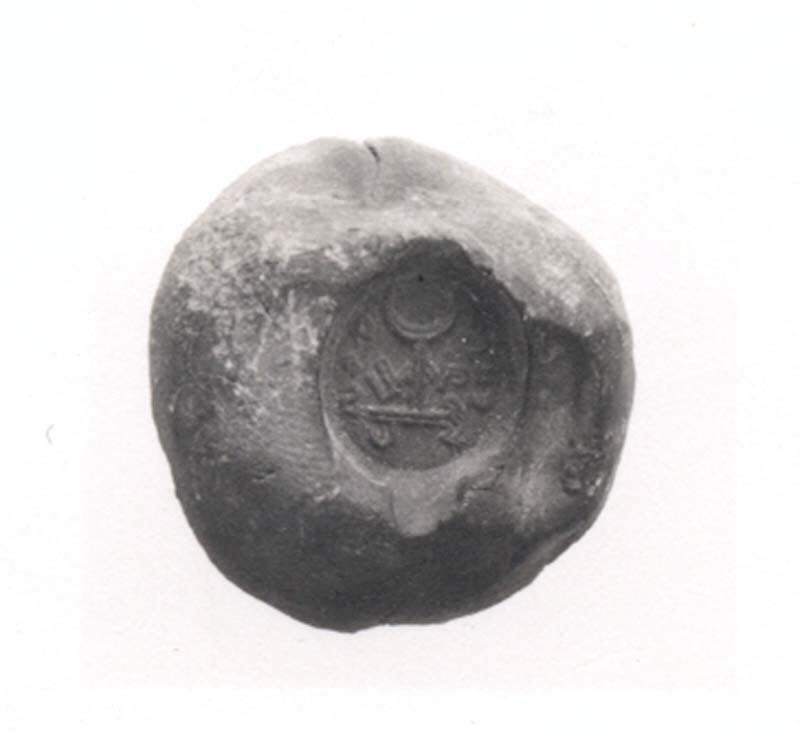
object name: sealing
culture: sasanian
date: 601-700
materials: clay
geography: iran